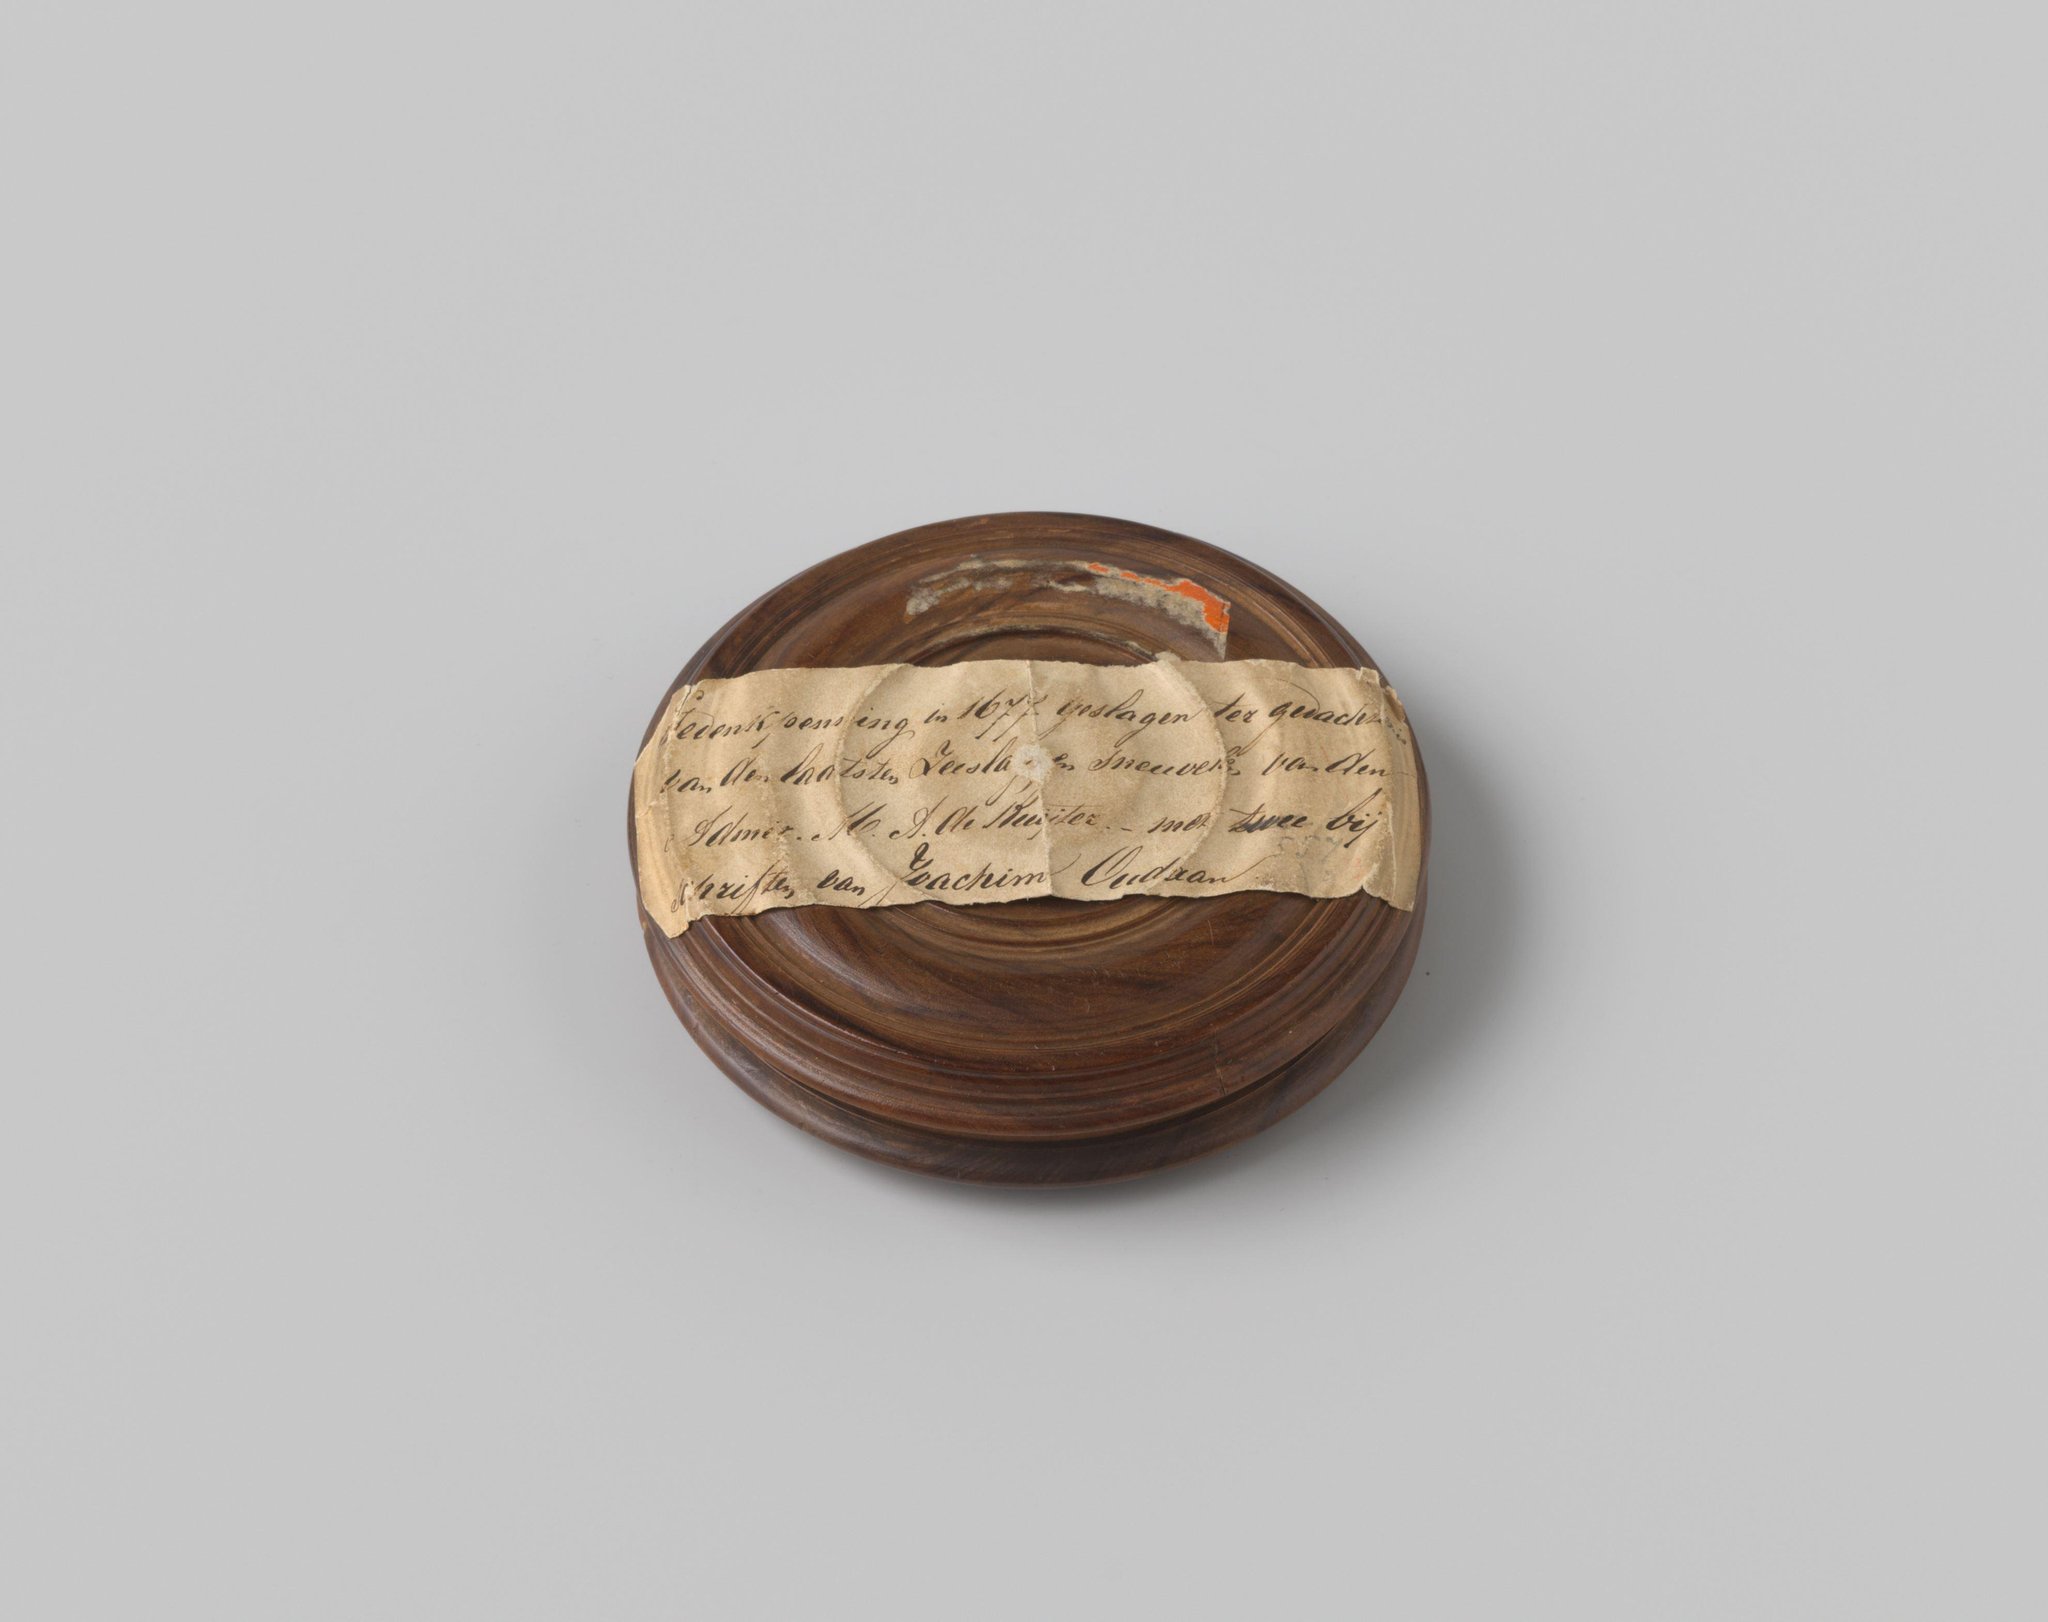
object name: medal box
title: Doosje bij penning van admiraal Michiel Adriaenszoon de Ruyter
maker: joachim oudaan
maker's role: geschiedschrijver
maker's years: 1628-1692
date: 1676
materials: paper, wood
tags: flushing, michiel adriaenszoon de ruyter, battle of etna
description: Houten rond penningdoosje. Zowel aan de binnenzijde van doosje, als in het deksel, een op papier geschreven veertienregelig gedicht.